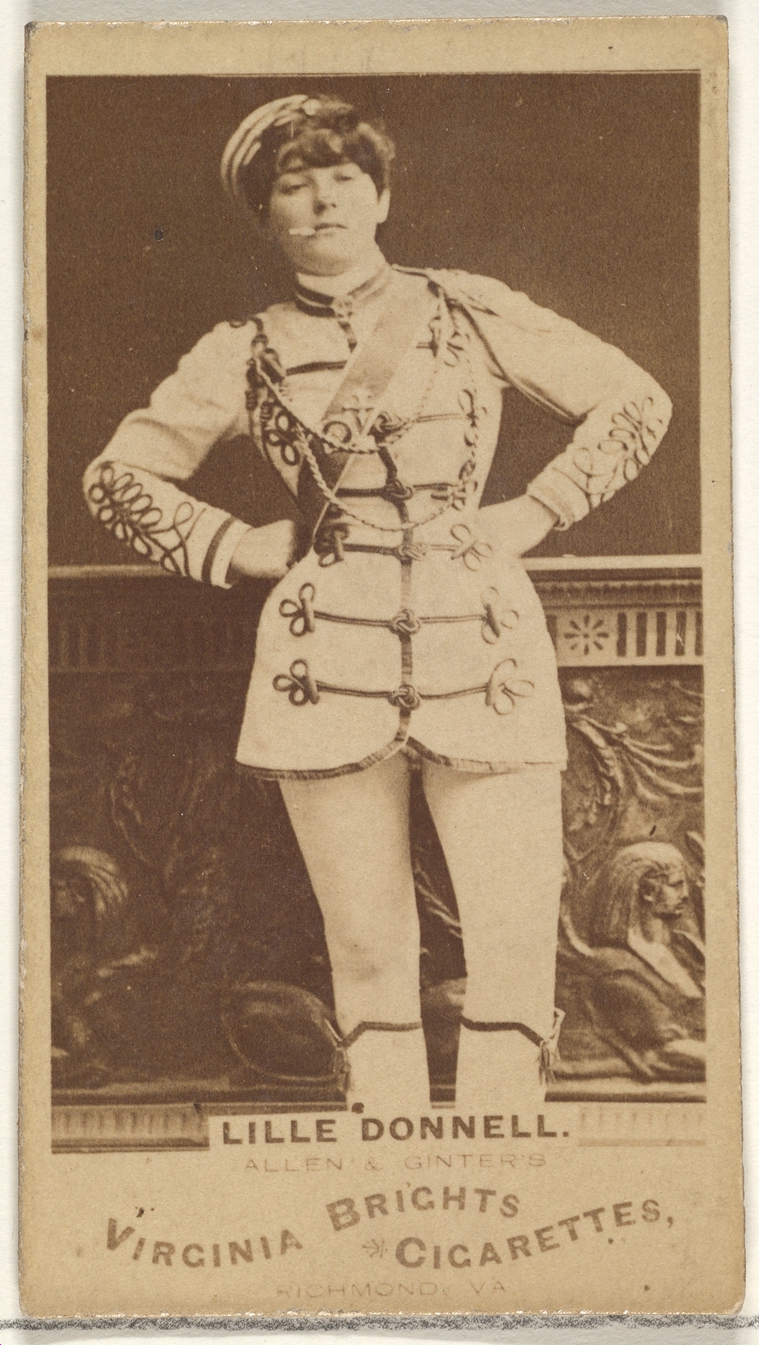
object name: photograph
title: Lille Donnell, from the Actors and Actresses series (N45, Type 1) for Virginia Brights Cigarettes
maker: allen & ginter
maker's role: publisher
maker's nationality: american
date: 1888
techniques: albumen silver print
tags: portraits,women,actresses